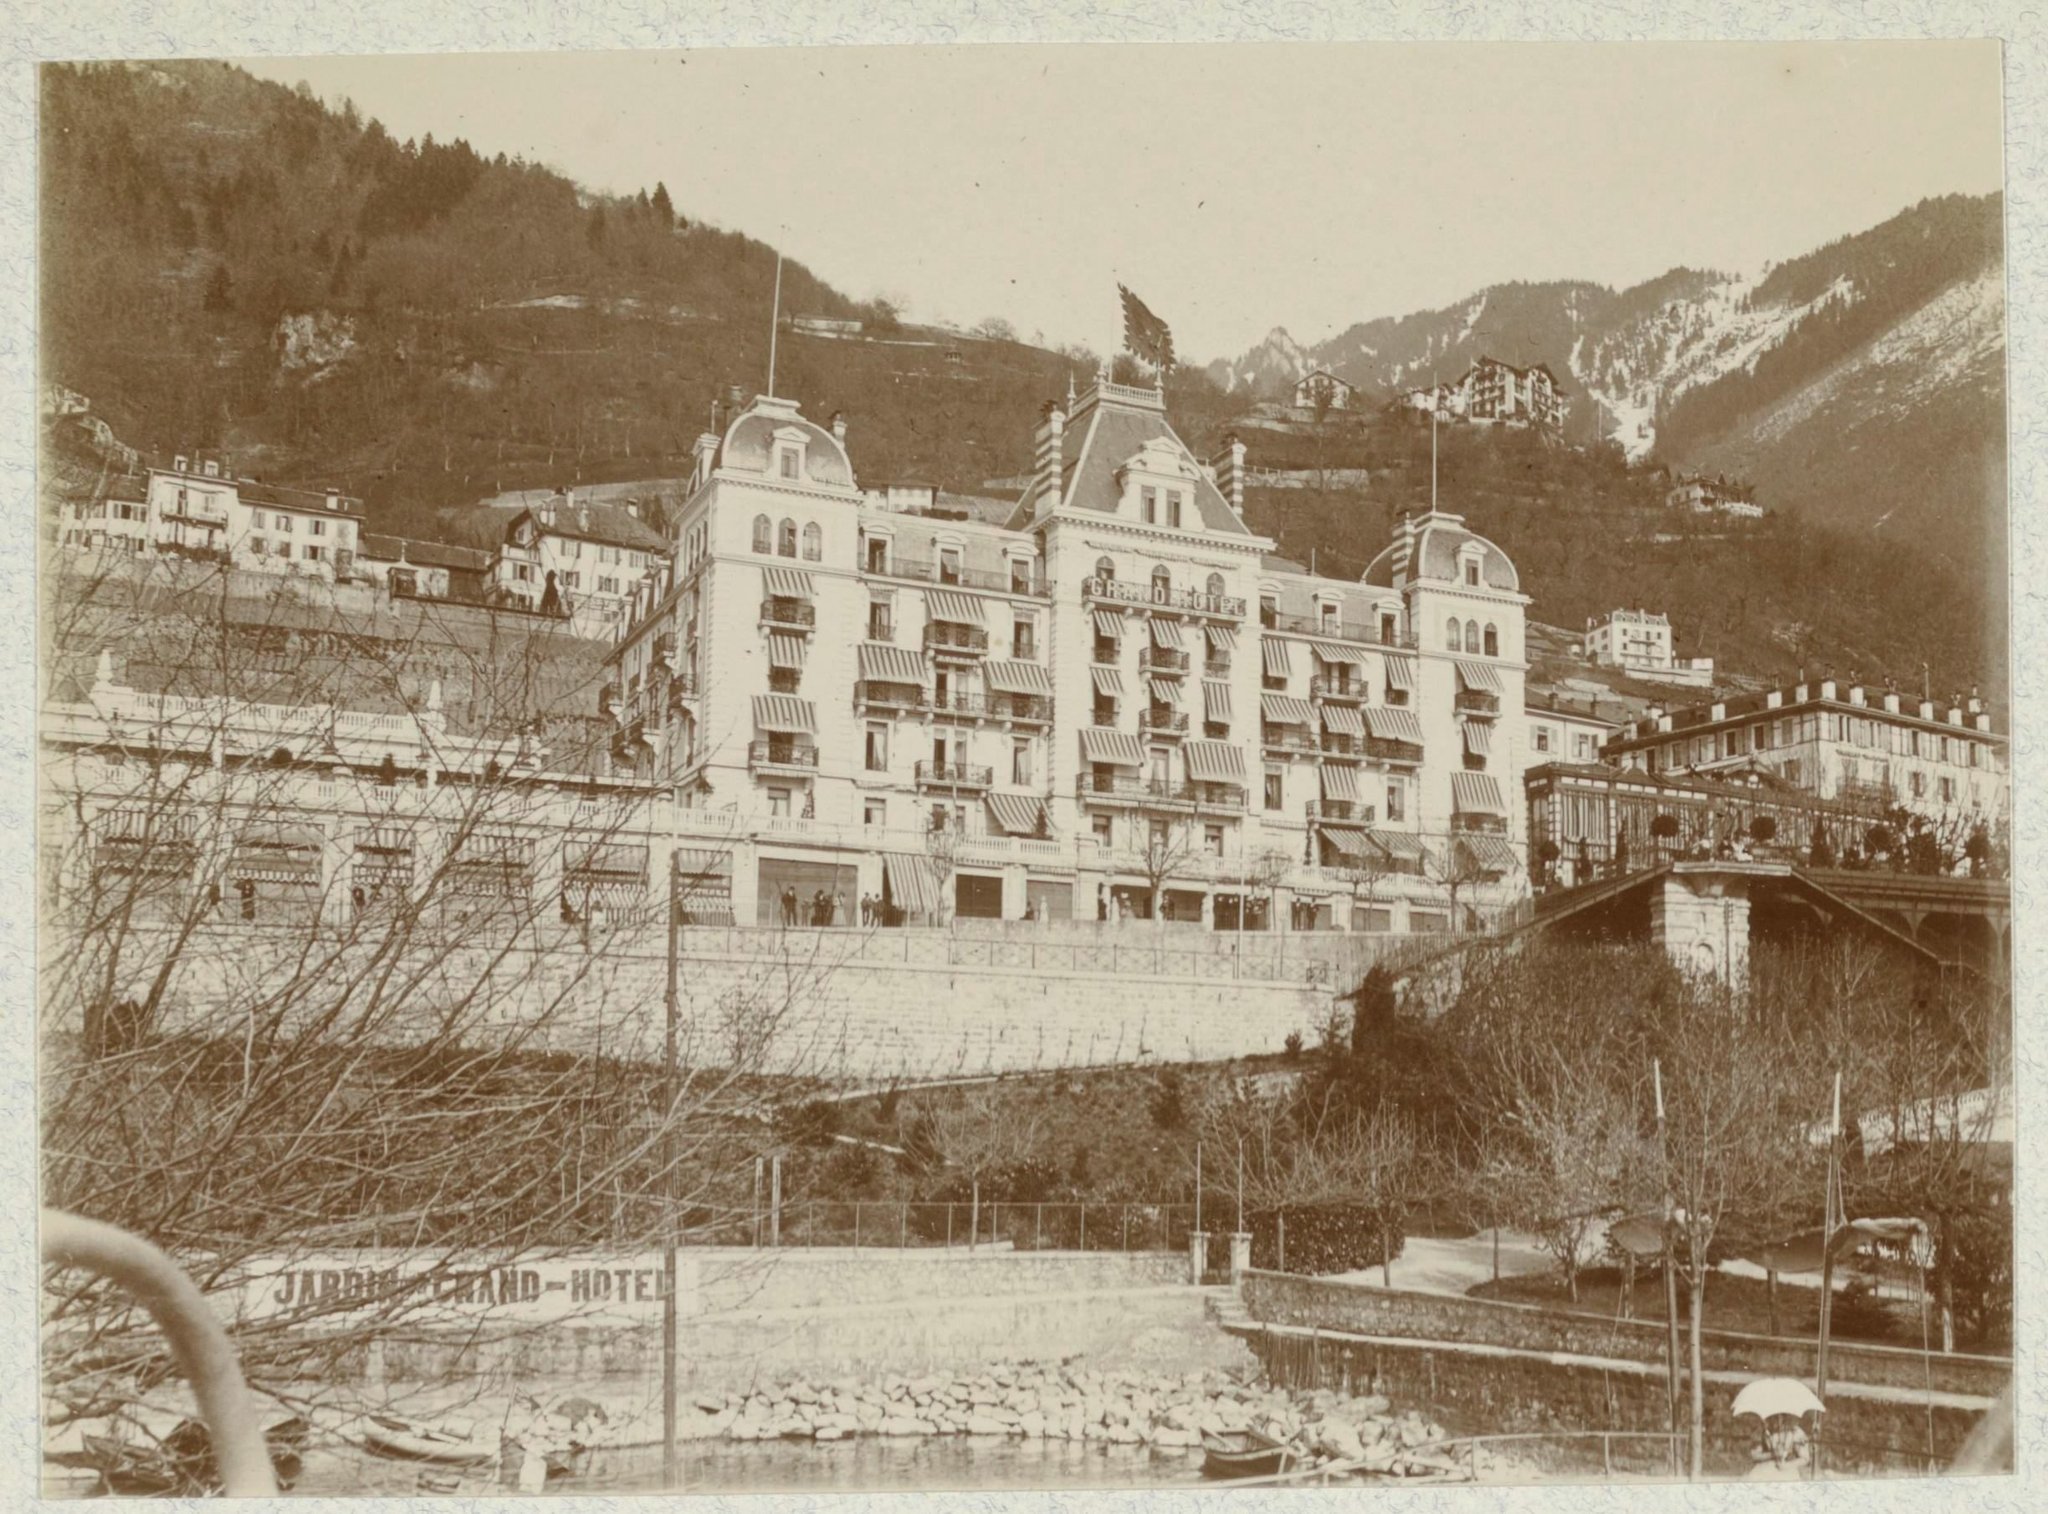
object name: photograph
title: Vakantie in Zwitserland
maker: andries augustus boom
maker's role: amateurfotograaf, handelaar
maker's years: 1878-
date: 1805-1899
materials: photographic support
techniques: photography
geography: switzerland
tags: andries augustus boom, switzerland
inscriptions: date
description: Vakantie in Zwitserland. Onderdeel van het fotoalbum van de familie Boom-Gonggrijp in Suriname en Curaçao.